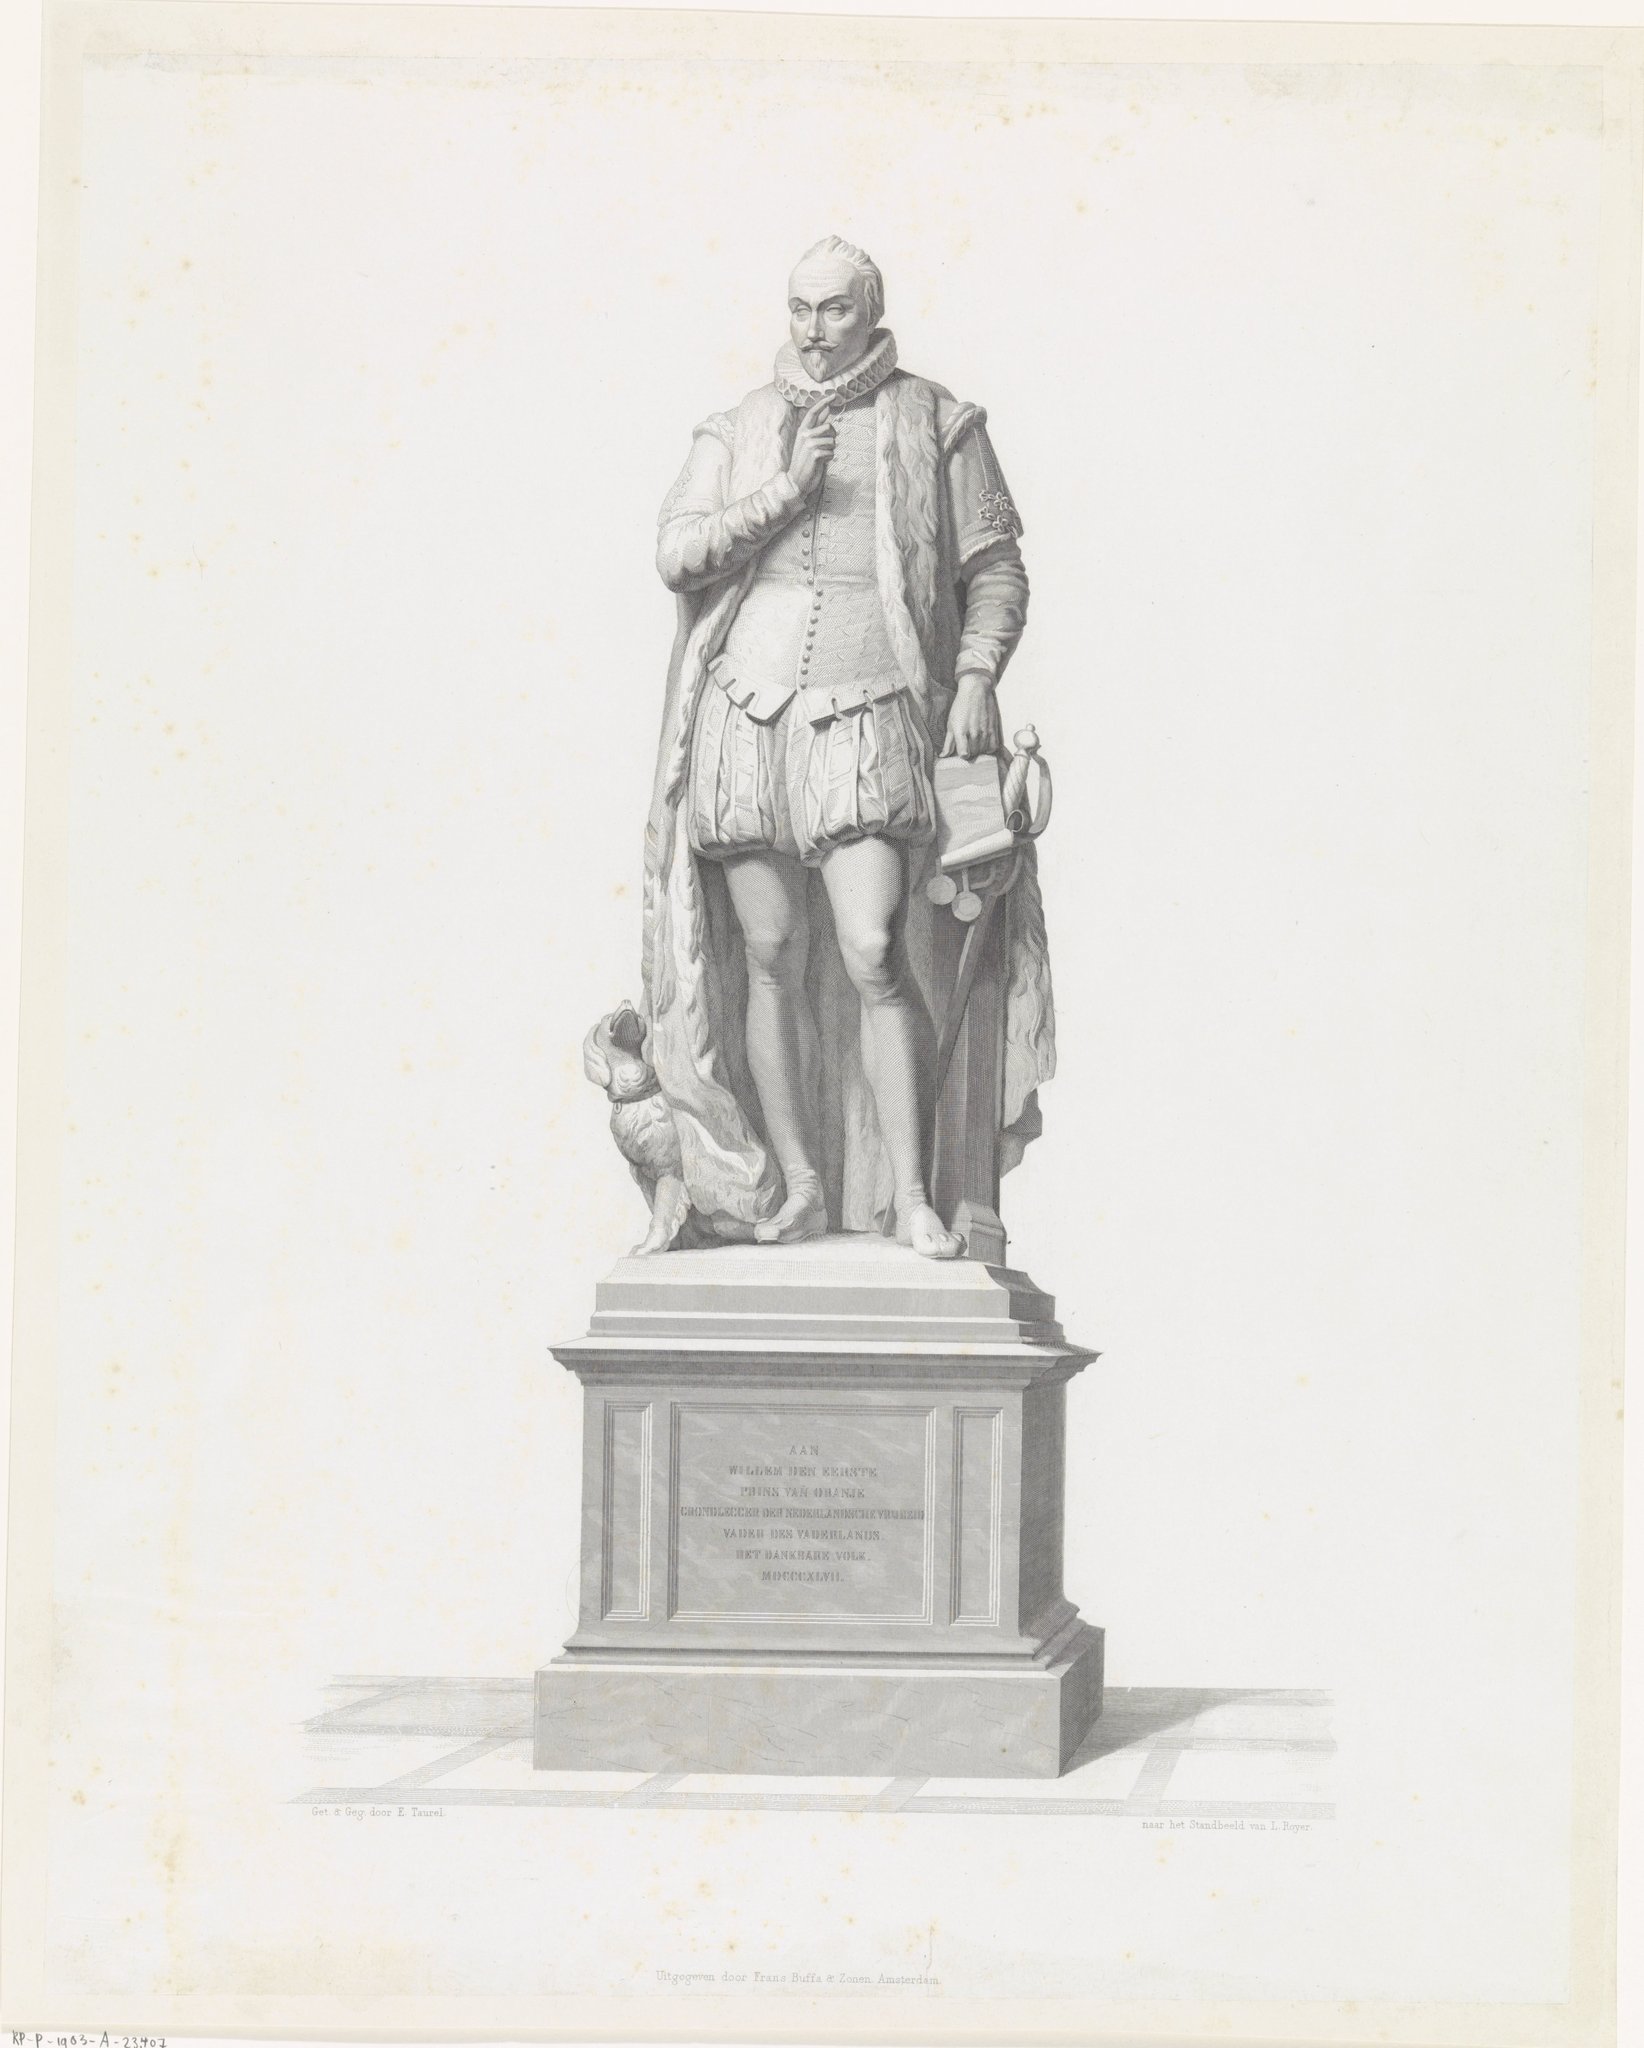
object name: print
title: Standbeeld van Prins Willem I op het Plein te Den Haag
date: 1847-1892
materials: paper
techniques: engraving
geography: amsterdam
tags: delft, william i (prince of orange), monument, statue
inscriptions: collector's mark: Lugt 2228, check stamp: ‘François Buffa & Fils’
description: Standbeeld van Prins Willem I door Louis Royer op het Plein te Den Haag.